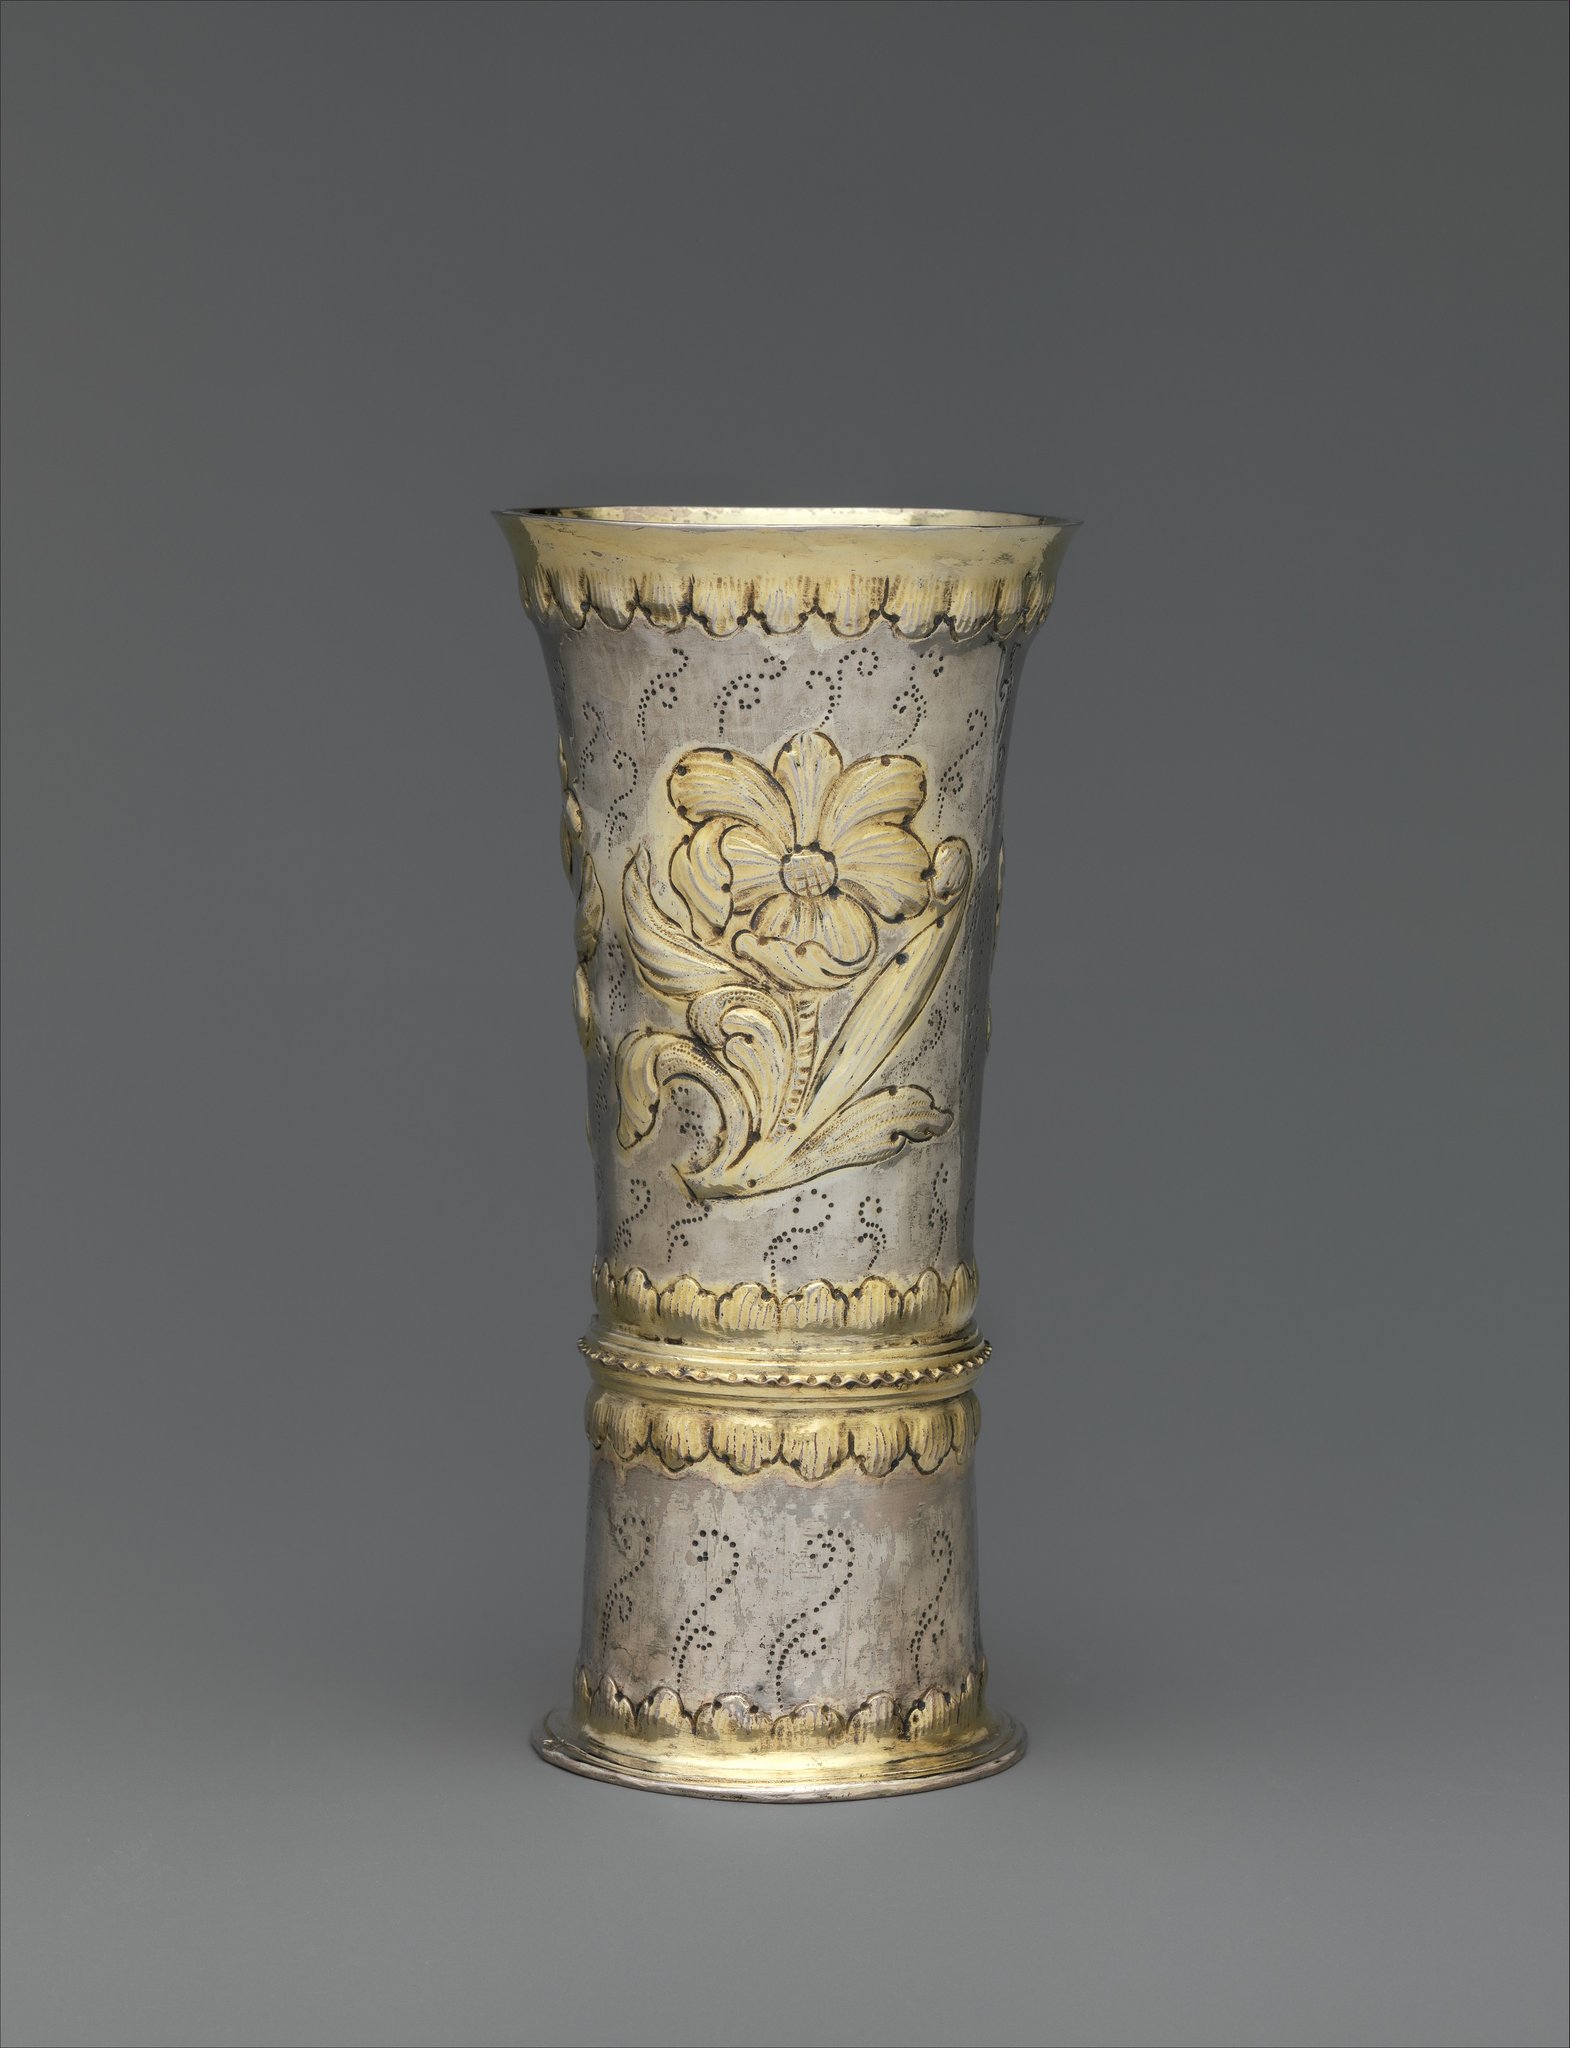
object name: beaker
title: Footed beaker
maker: georgius gebell ii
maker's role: maker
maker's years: 1553-1653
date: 1634-1666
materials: silver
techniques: gilding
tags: flowers